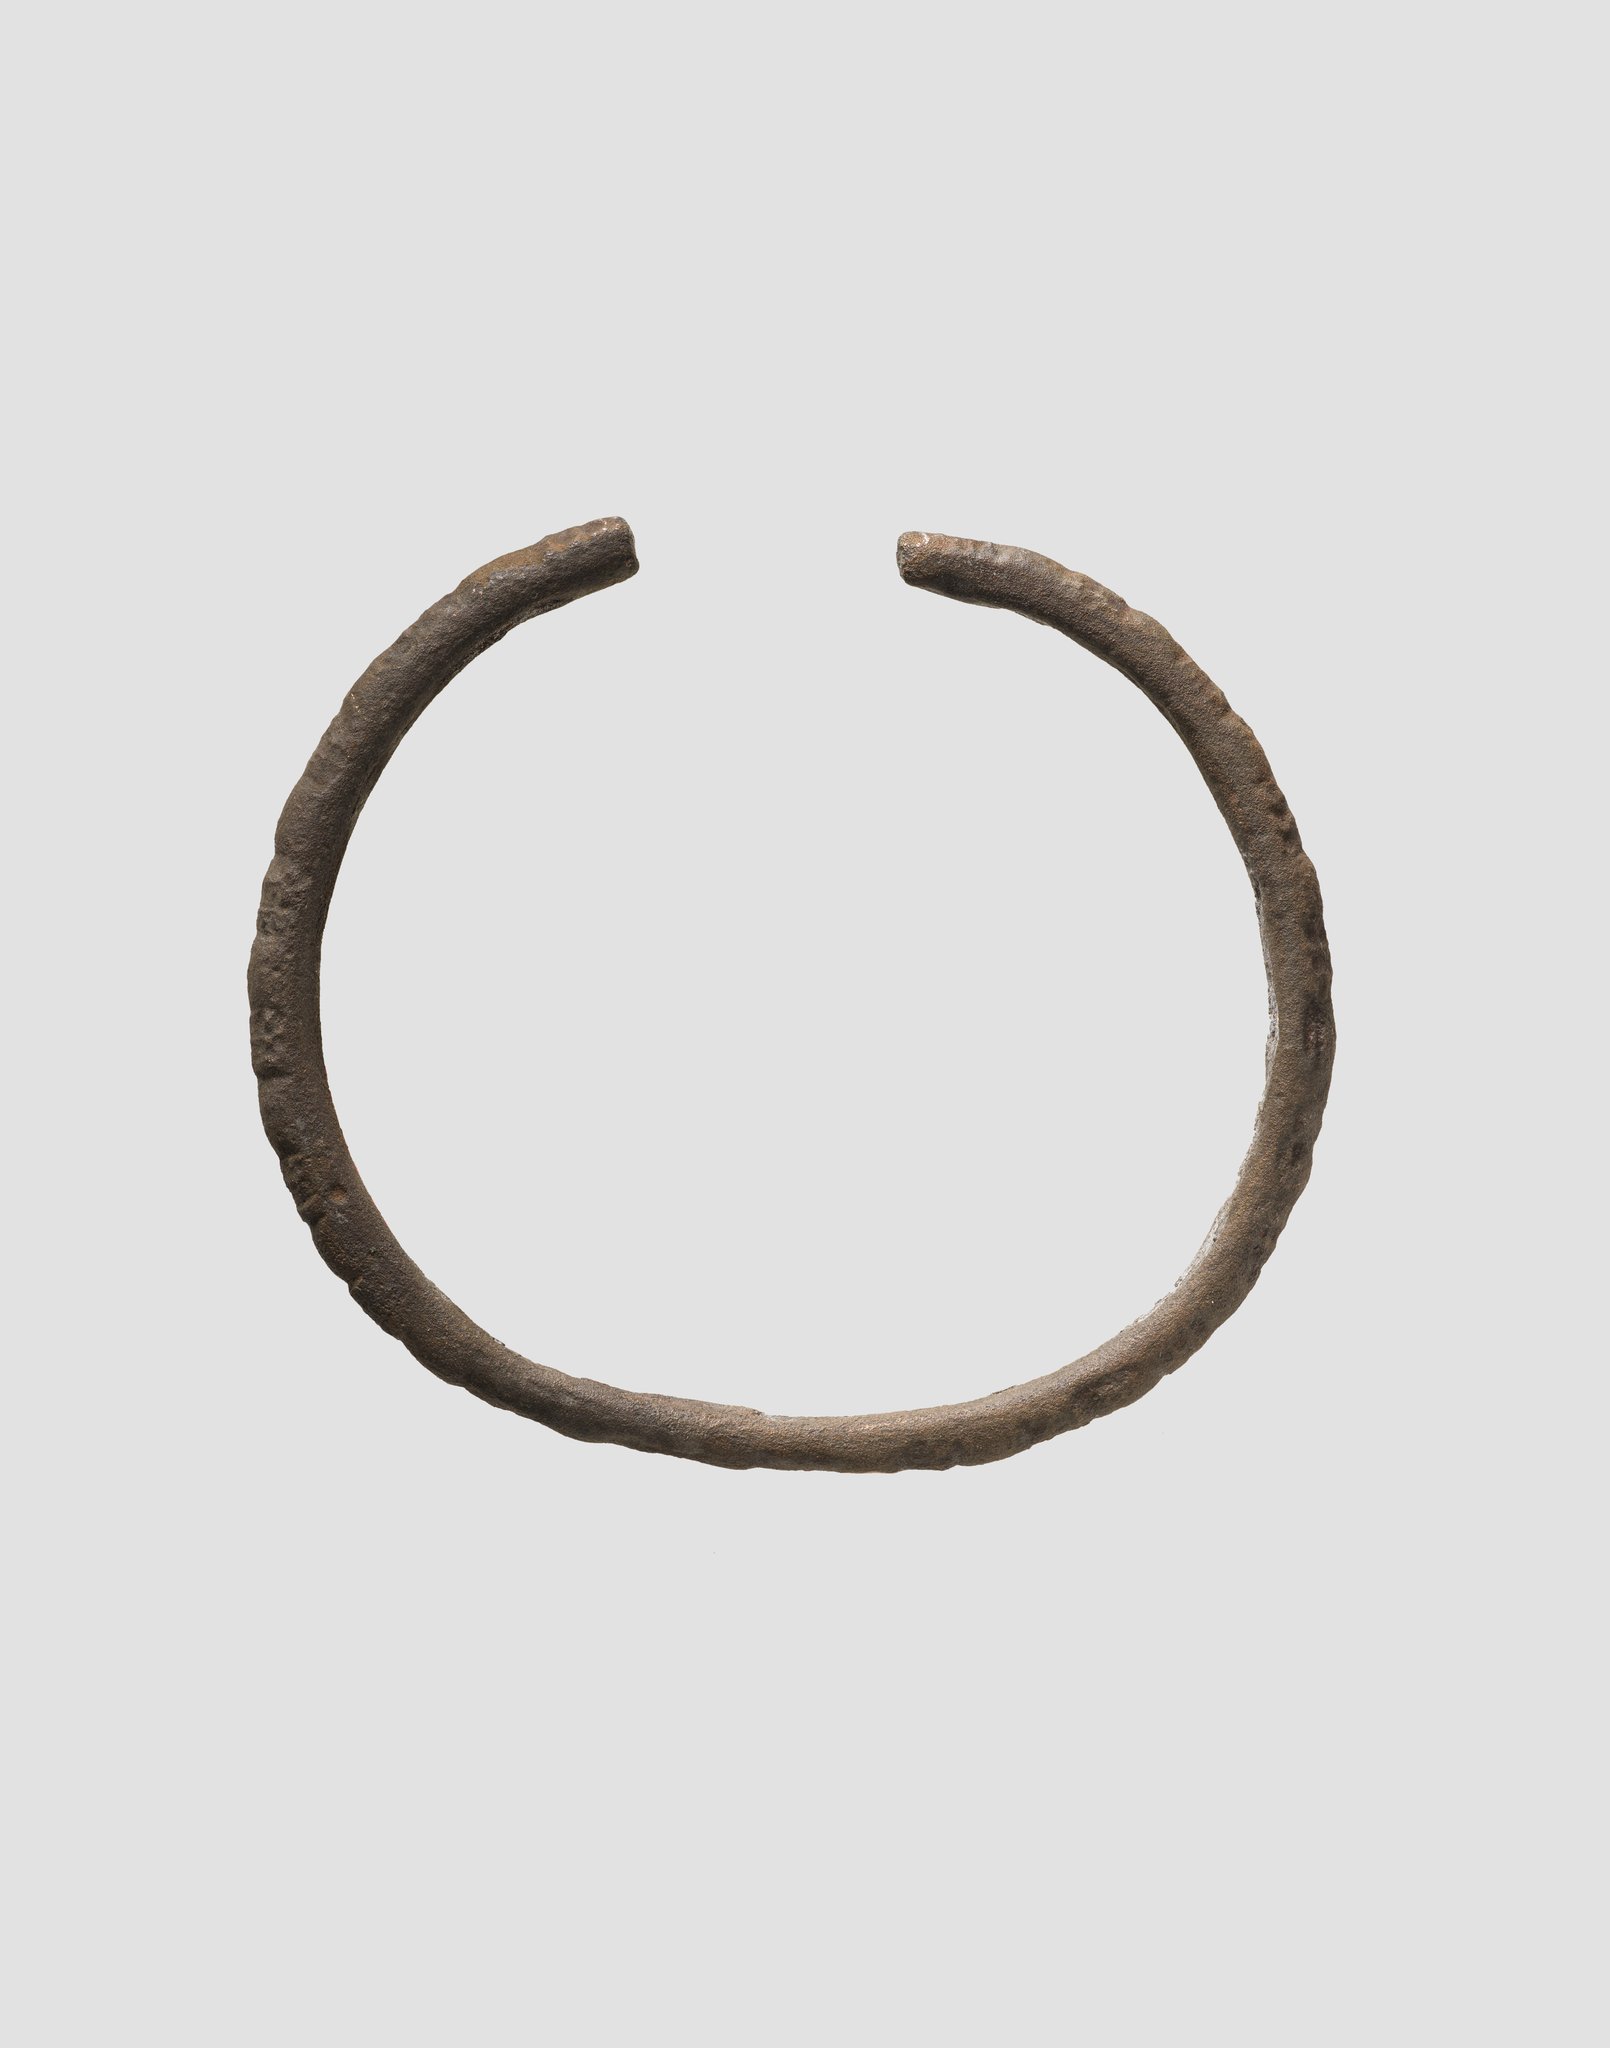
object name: bracelet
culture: iranian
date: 900-801 BCE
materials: bronze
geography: iran